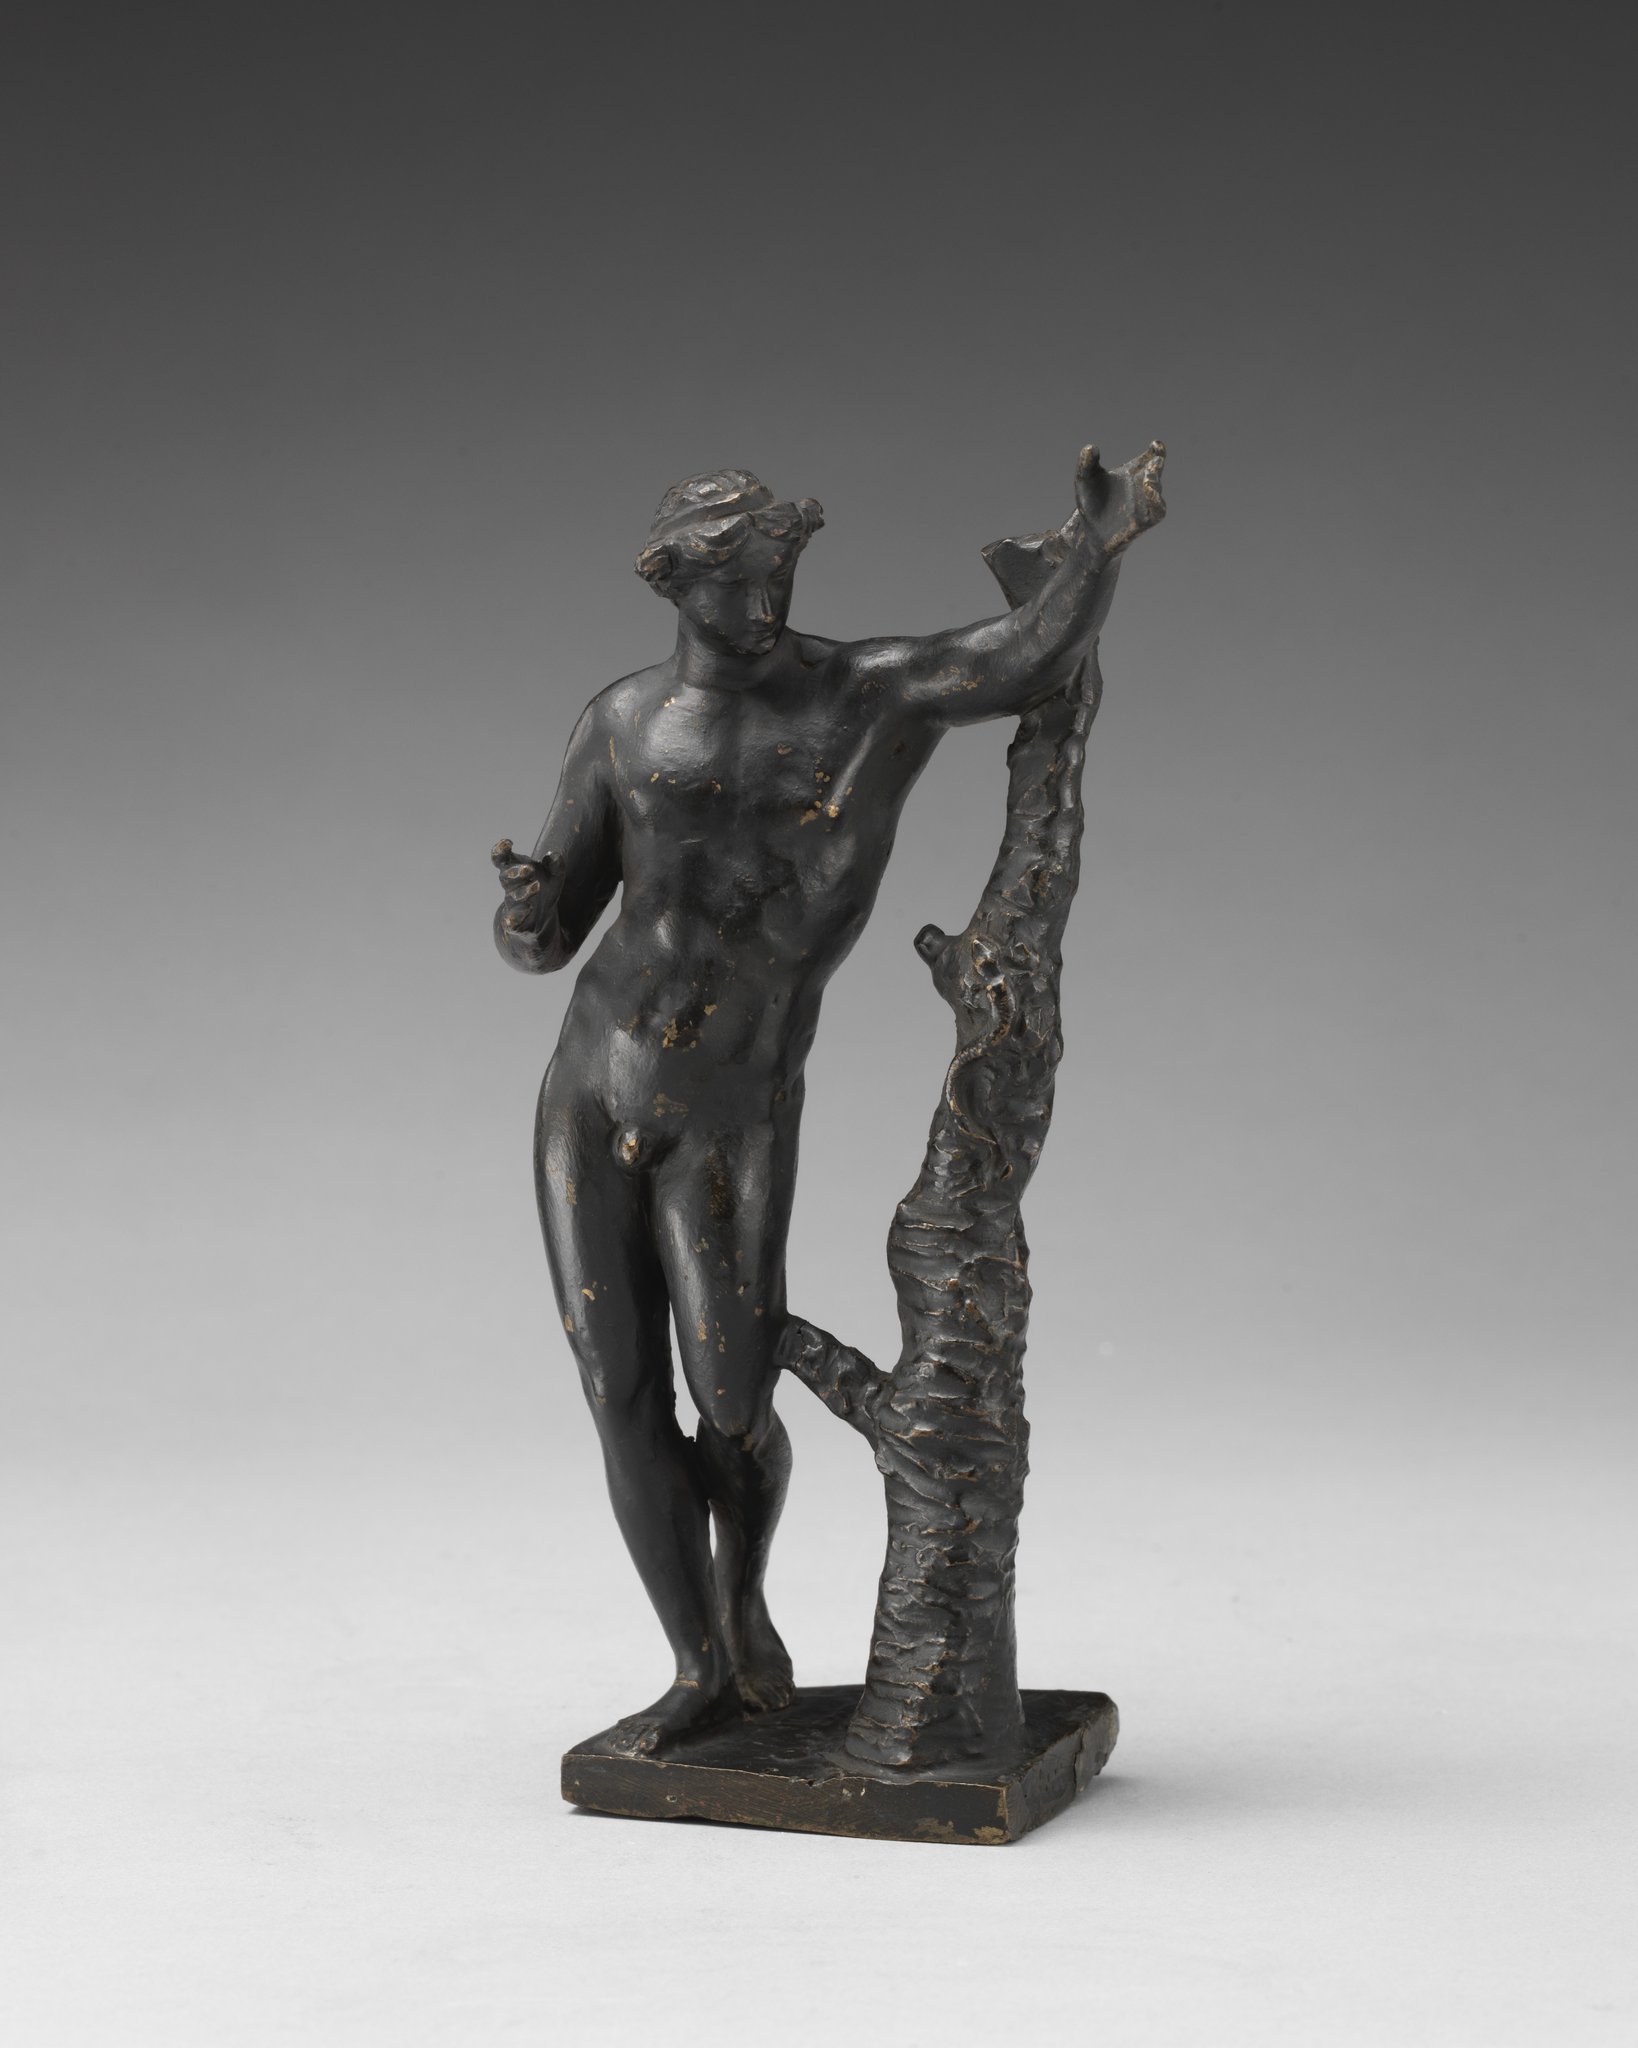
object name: statuette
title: Apollo Sauroktonos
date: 1701-1900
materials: bronze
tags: male nudes,portraits